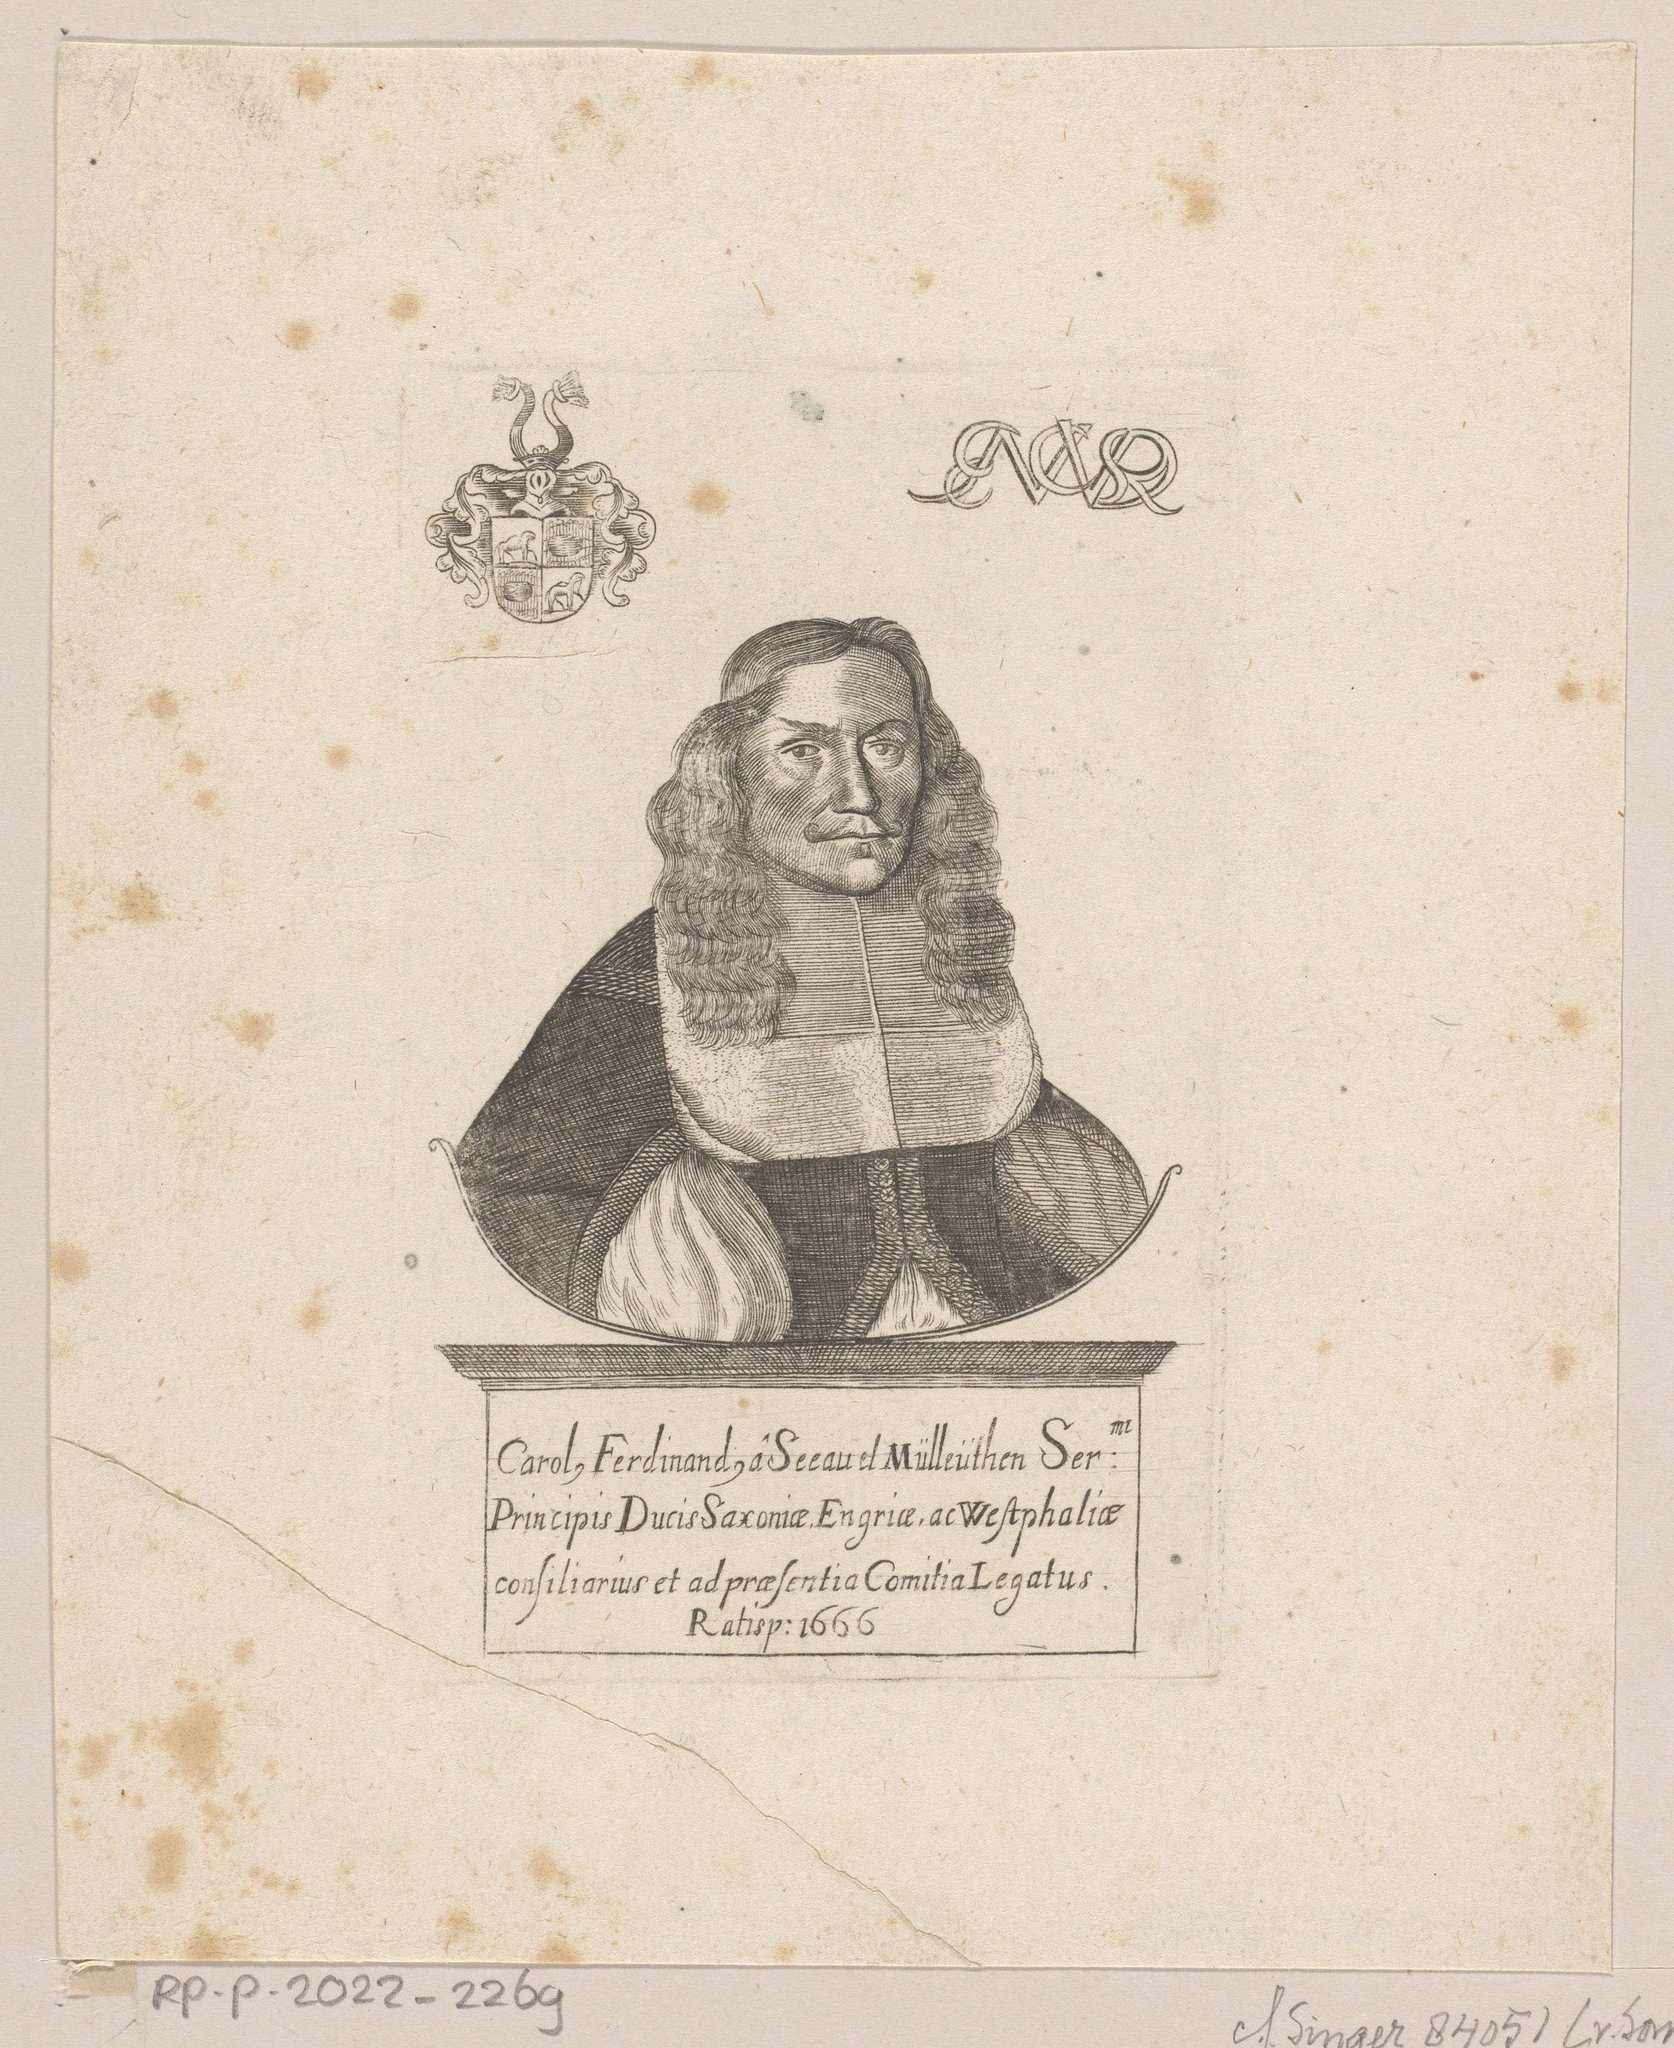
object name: print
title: Portret van Carl Ferdinand von Seeau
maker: Anonymous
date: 1666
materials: paper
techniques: engraving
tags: official; civil servant; functionary (in general), historical persons, armorial bearing, heraldry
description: Met vierregelig onderschrift in het Latijn.